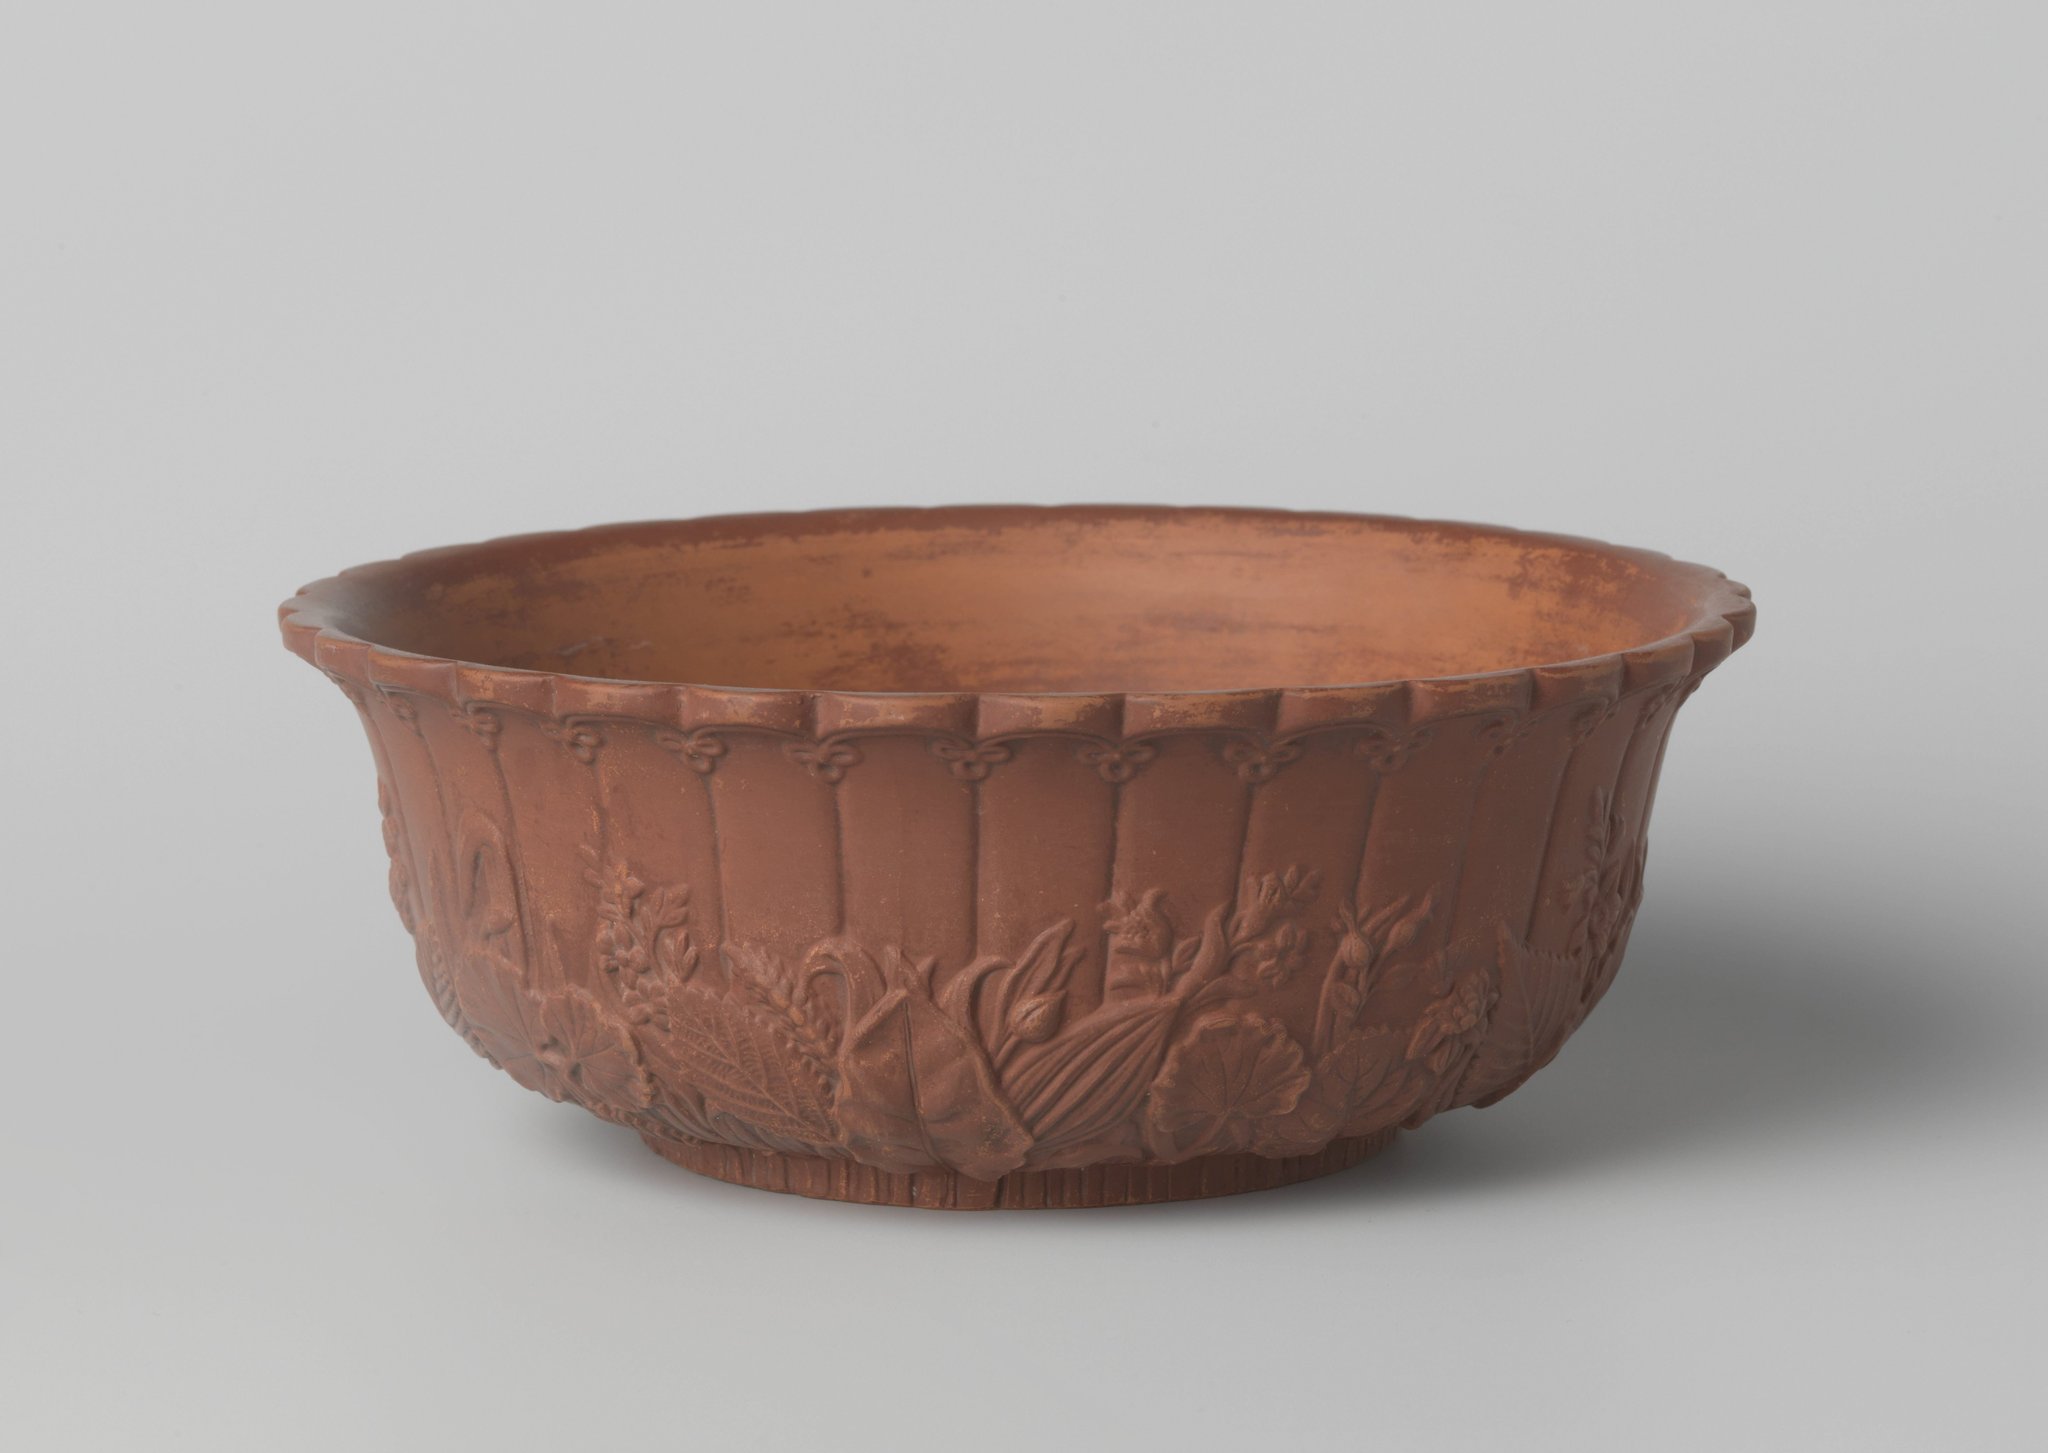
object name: slop bowl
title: Spoelkom, geschulpt, met bloemen en bladeren in reliëf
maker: Anonymous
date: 1400-1950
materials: terracotta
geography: germany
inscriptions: check stamp: ‘WS & Ss // 72’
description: Spoelkom van terracotta. Het geschulpte lichaam met bloemen en bladeren in reliëf.